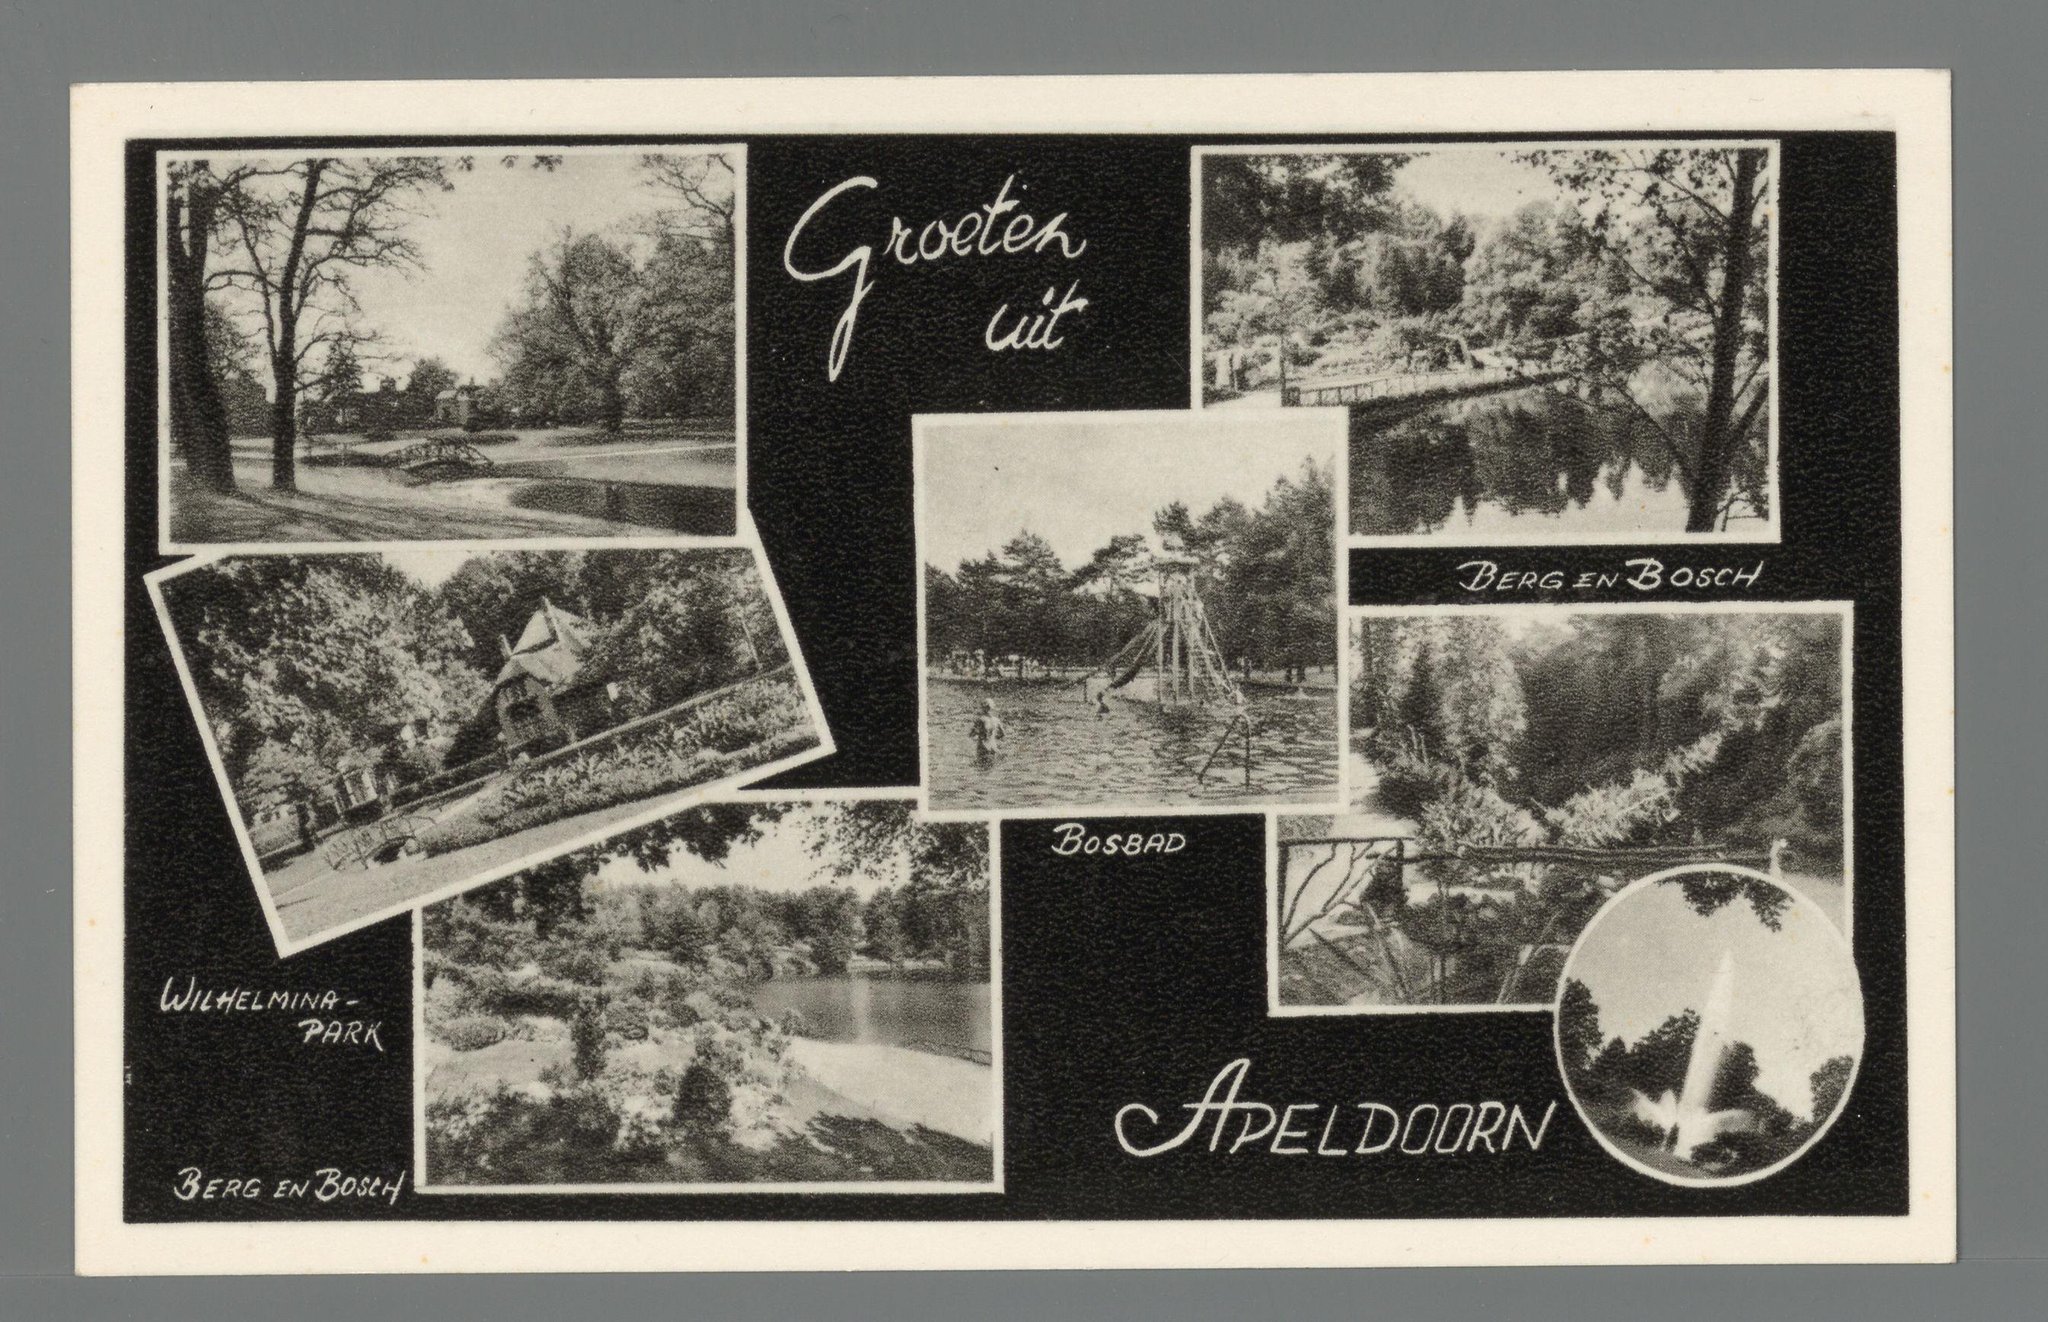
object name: photomechanical print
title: Kasteel Ammersoyen te Ammerzoden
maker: Anonymous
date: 1976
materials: cardboard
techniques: offset printed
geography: ammerzoden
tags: castle, canal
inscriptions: date